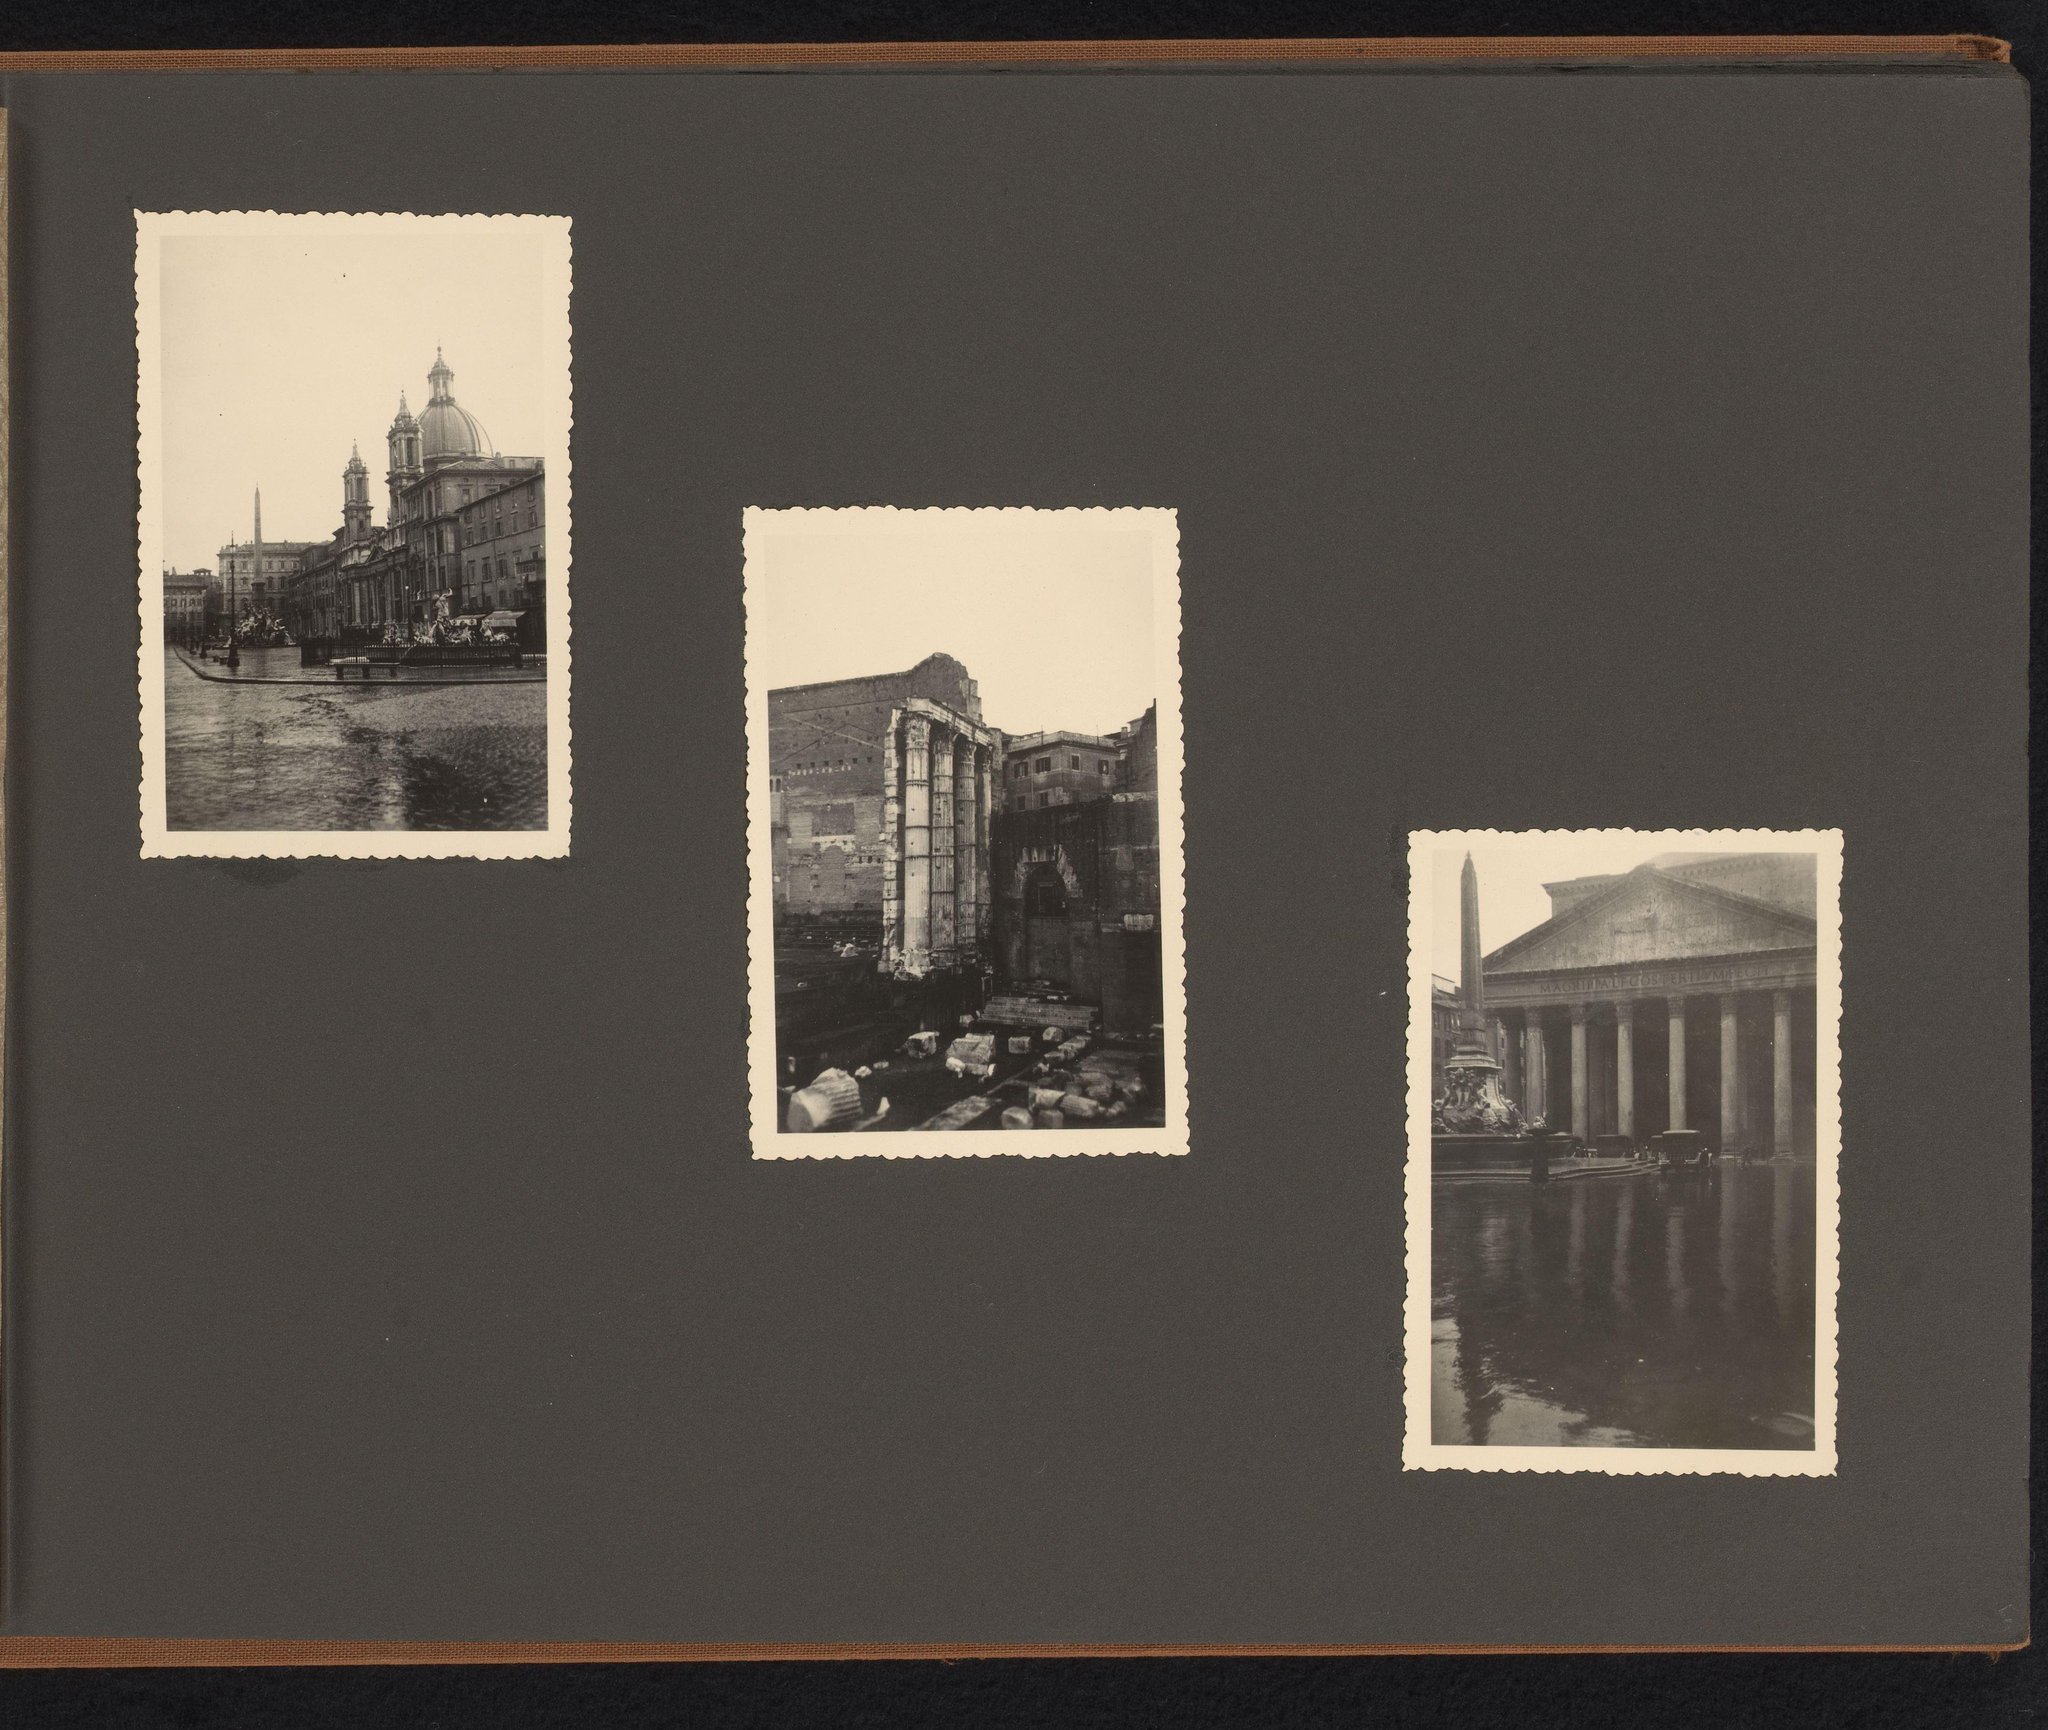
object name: album leaf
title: Gezicht op de Sint-Pietersbasiliek, ruïnes en het Pantheon te Rome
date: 1936-1939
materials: cardboard, paper, photographic support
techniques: gelatin silver print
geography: rome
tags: church (exterior), ruin of a dwelling, house, castle, etc., street (+ city(-scape) with figures, staffage)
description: Drie foto's gemaakt tijdens de vakantie van Berti Hoppe en Herman Besselaar naar Rome. Deze pagina maakt deel uit van een album.